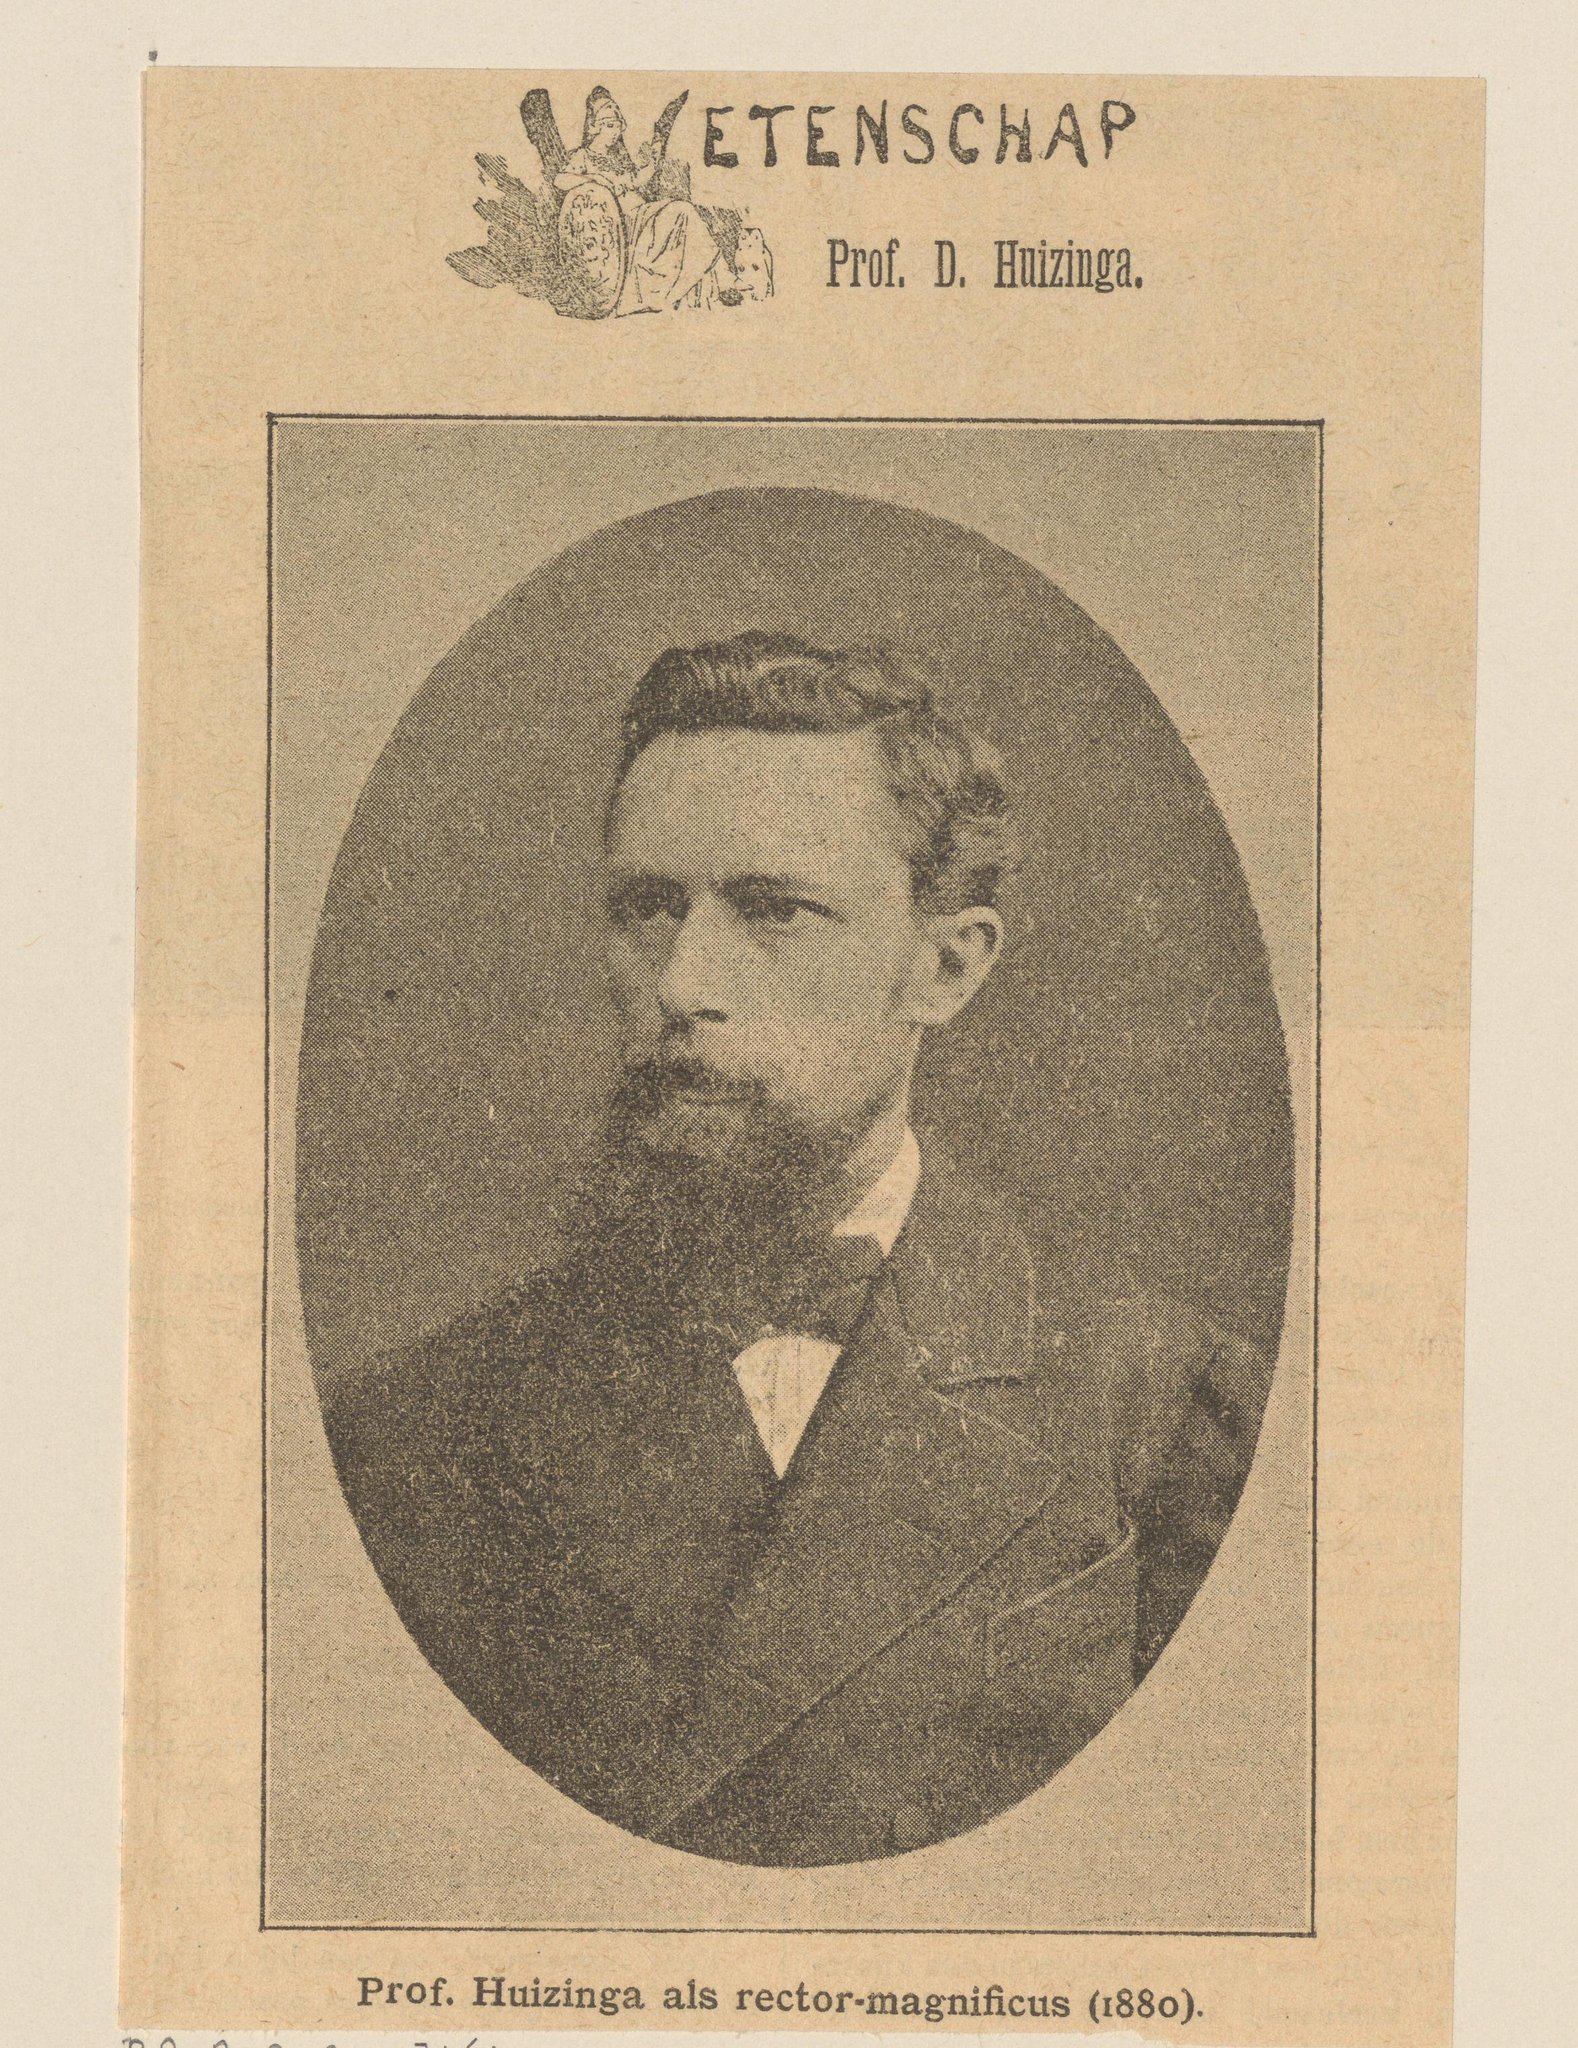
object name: photomechanical print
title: Portret van Dirk Huizinga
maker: Anonymous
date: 1895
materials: paper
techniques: letterpress printing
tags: historical persons, professor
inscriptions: inscription: ‘[...] Januari 1895’